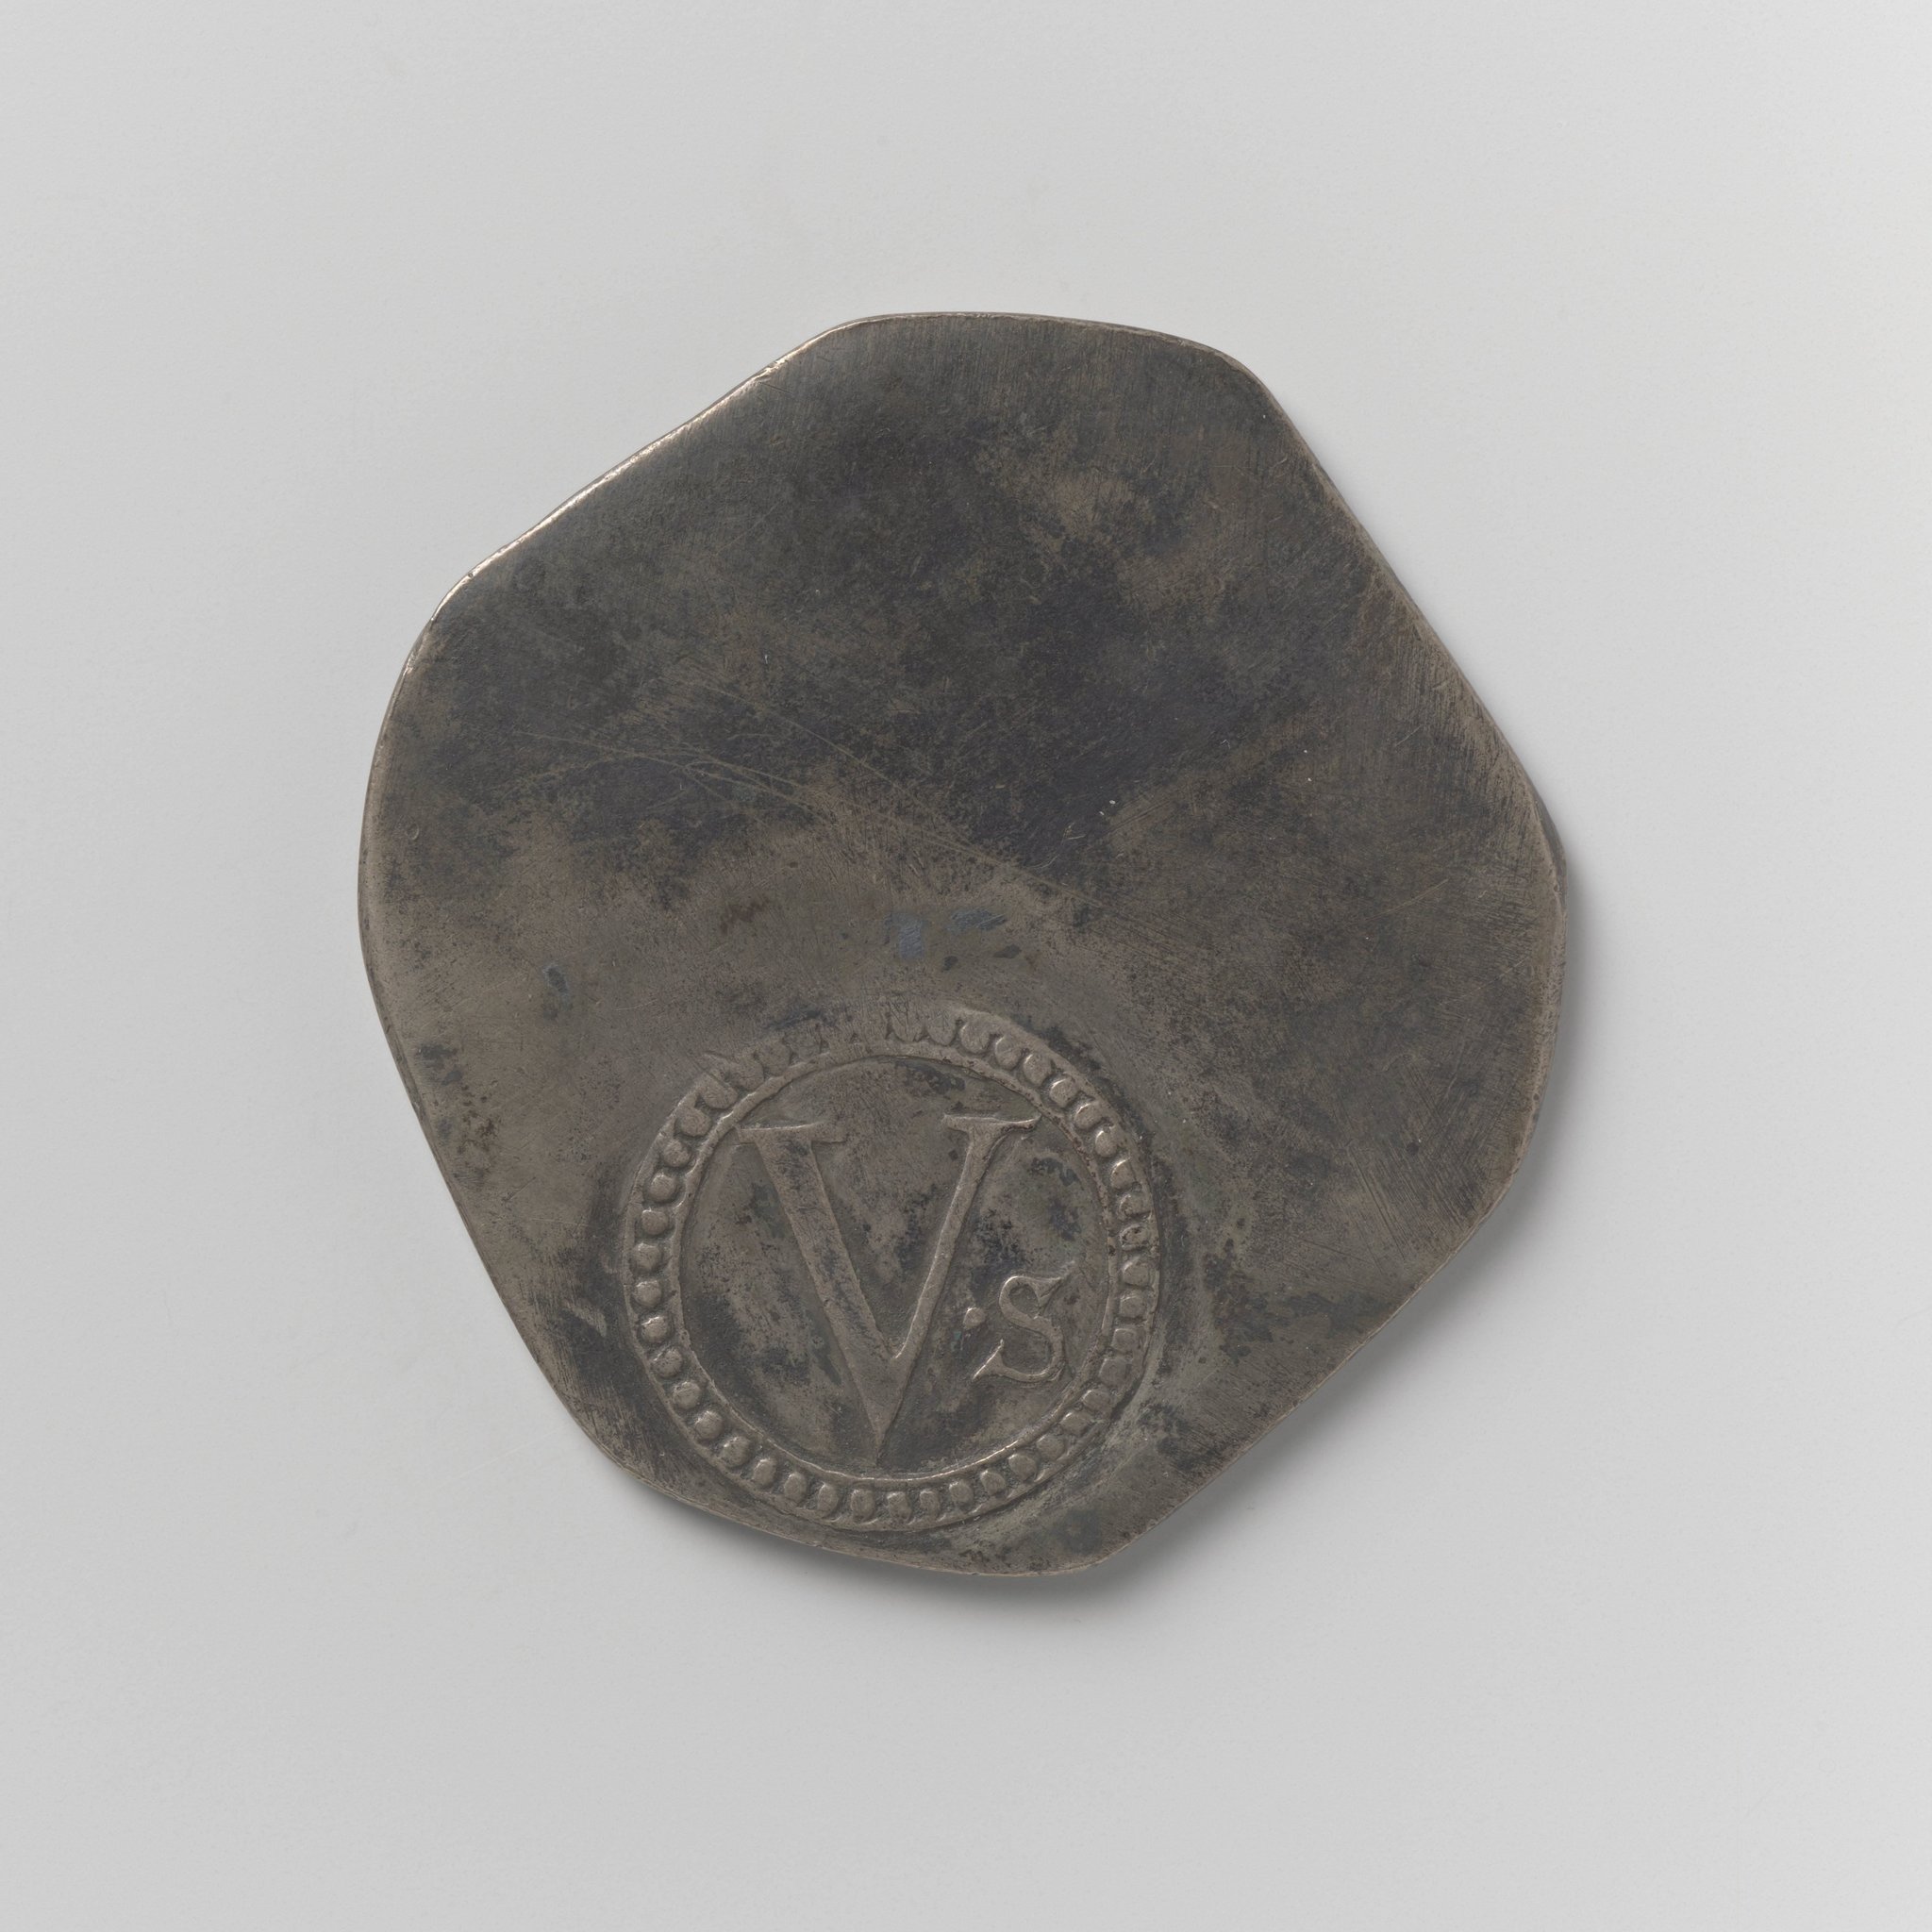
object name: vijf shilling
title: Vijf shilling, noodmunt van Karel I, koning van Engeland te Ormond geslagen van het door de ingezetenen opgebrachte zilver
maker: Anonymous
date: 1642-1648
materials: silver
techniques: striking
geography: ireland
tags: london, karel i (koning van engeland)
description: Eenzijdige, ruitvormige zilveren noodmunt met afgeschuinde hoeken. Voorzijde: onderaan: in ronde stempel: grote letter V en kleine S binnen parelrand. Keerzijde: blanco. Crown.